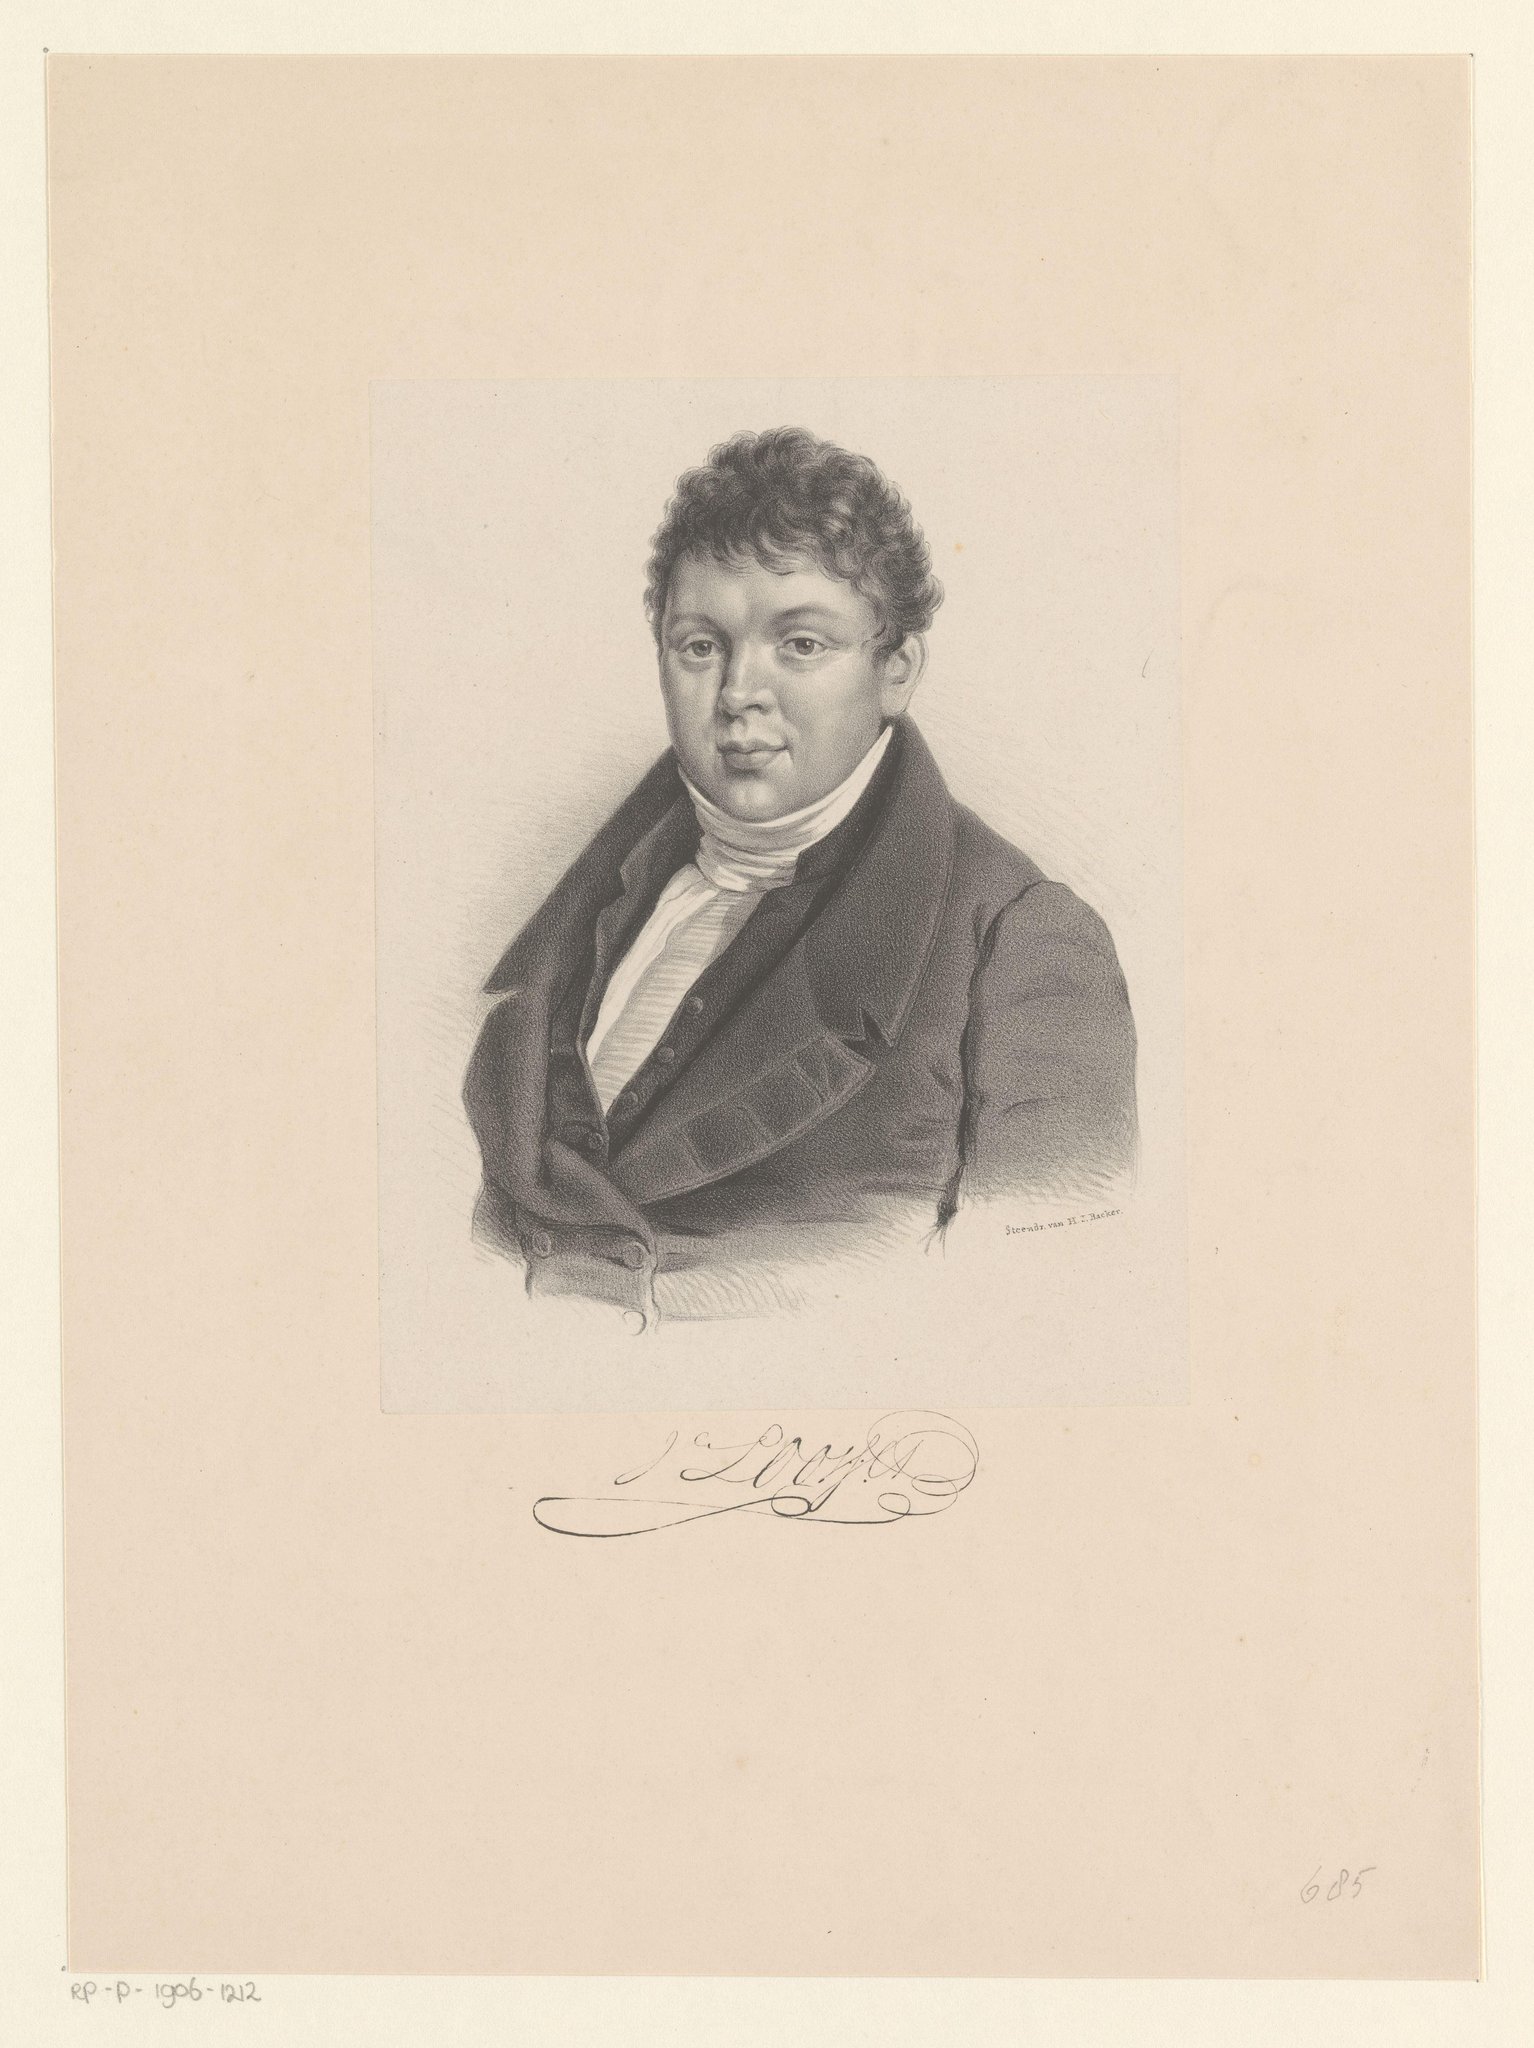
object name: print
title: Portret van Vincent Loosjes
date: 1822-1845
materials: paper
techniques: lithograph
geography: dordrecht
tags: haarlem, vincent loosjes, historical persons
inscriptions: collector's mark: Lugt 2228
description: Onder het portret de signatuur van de geportretteerde.